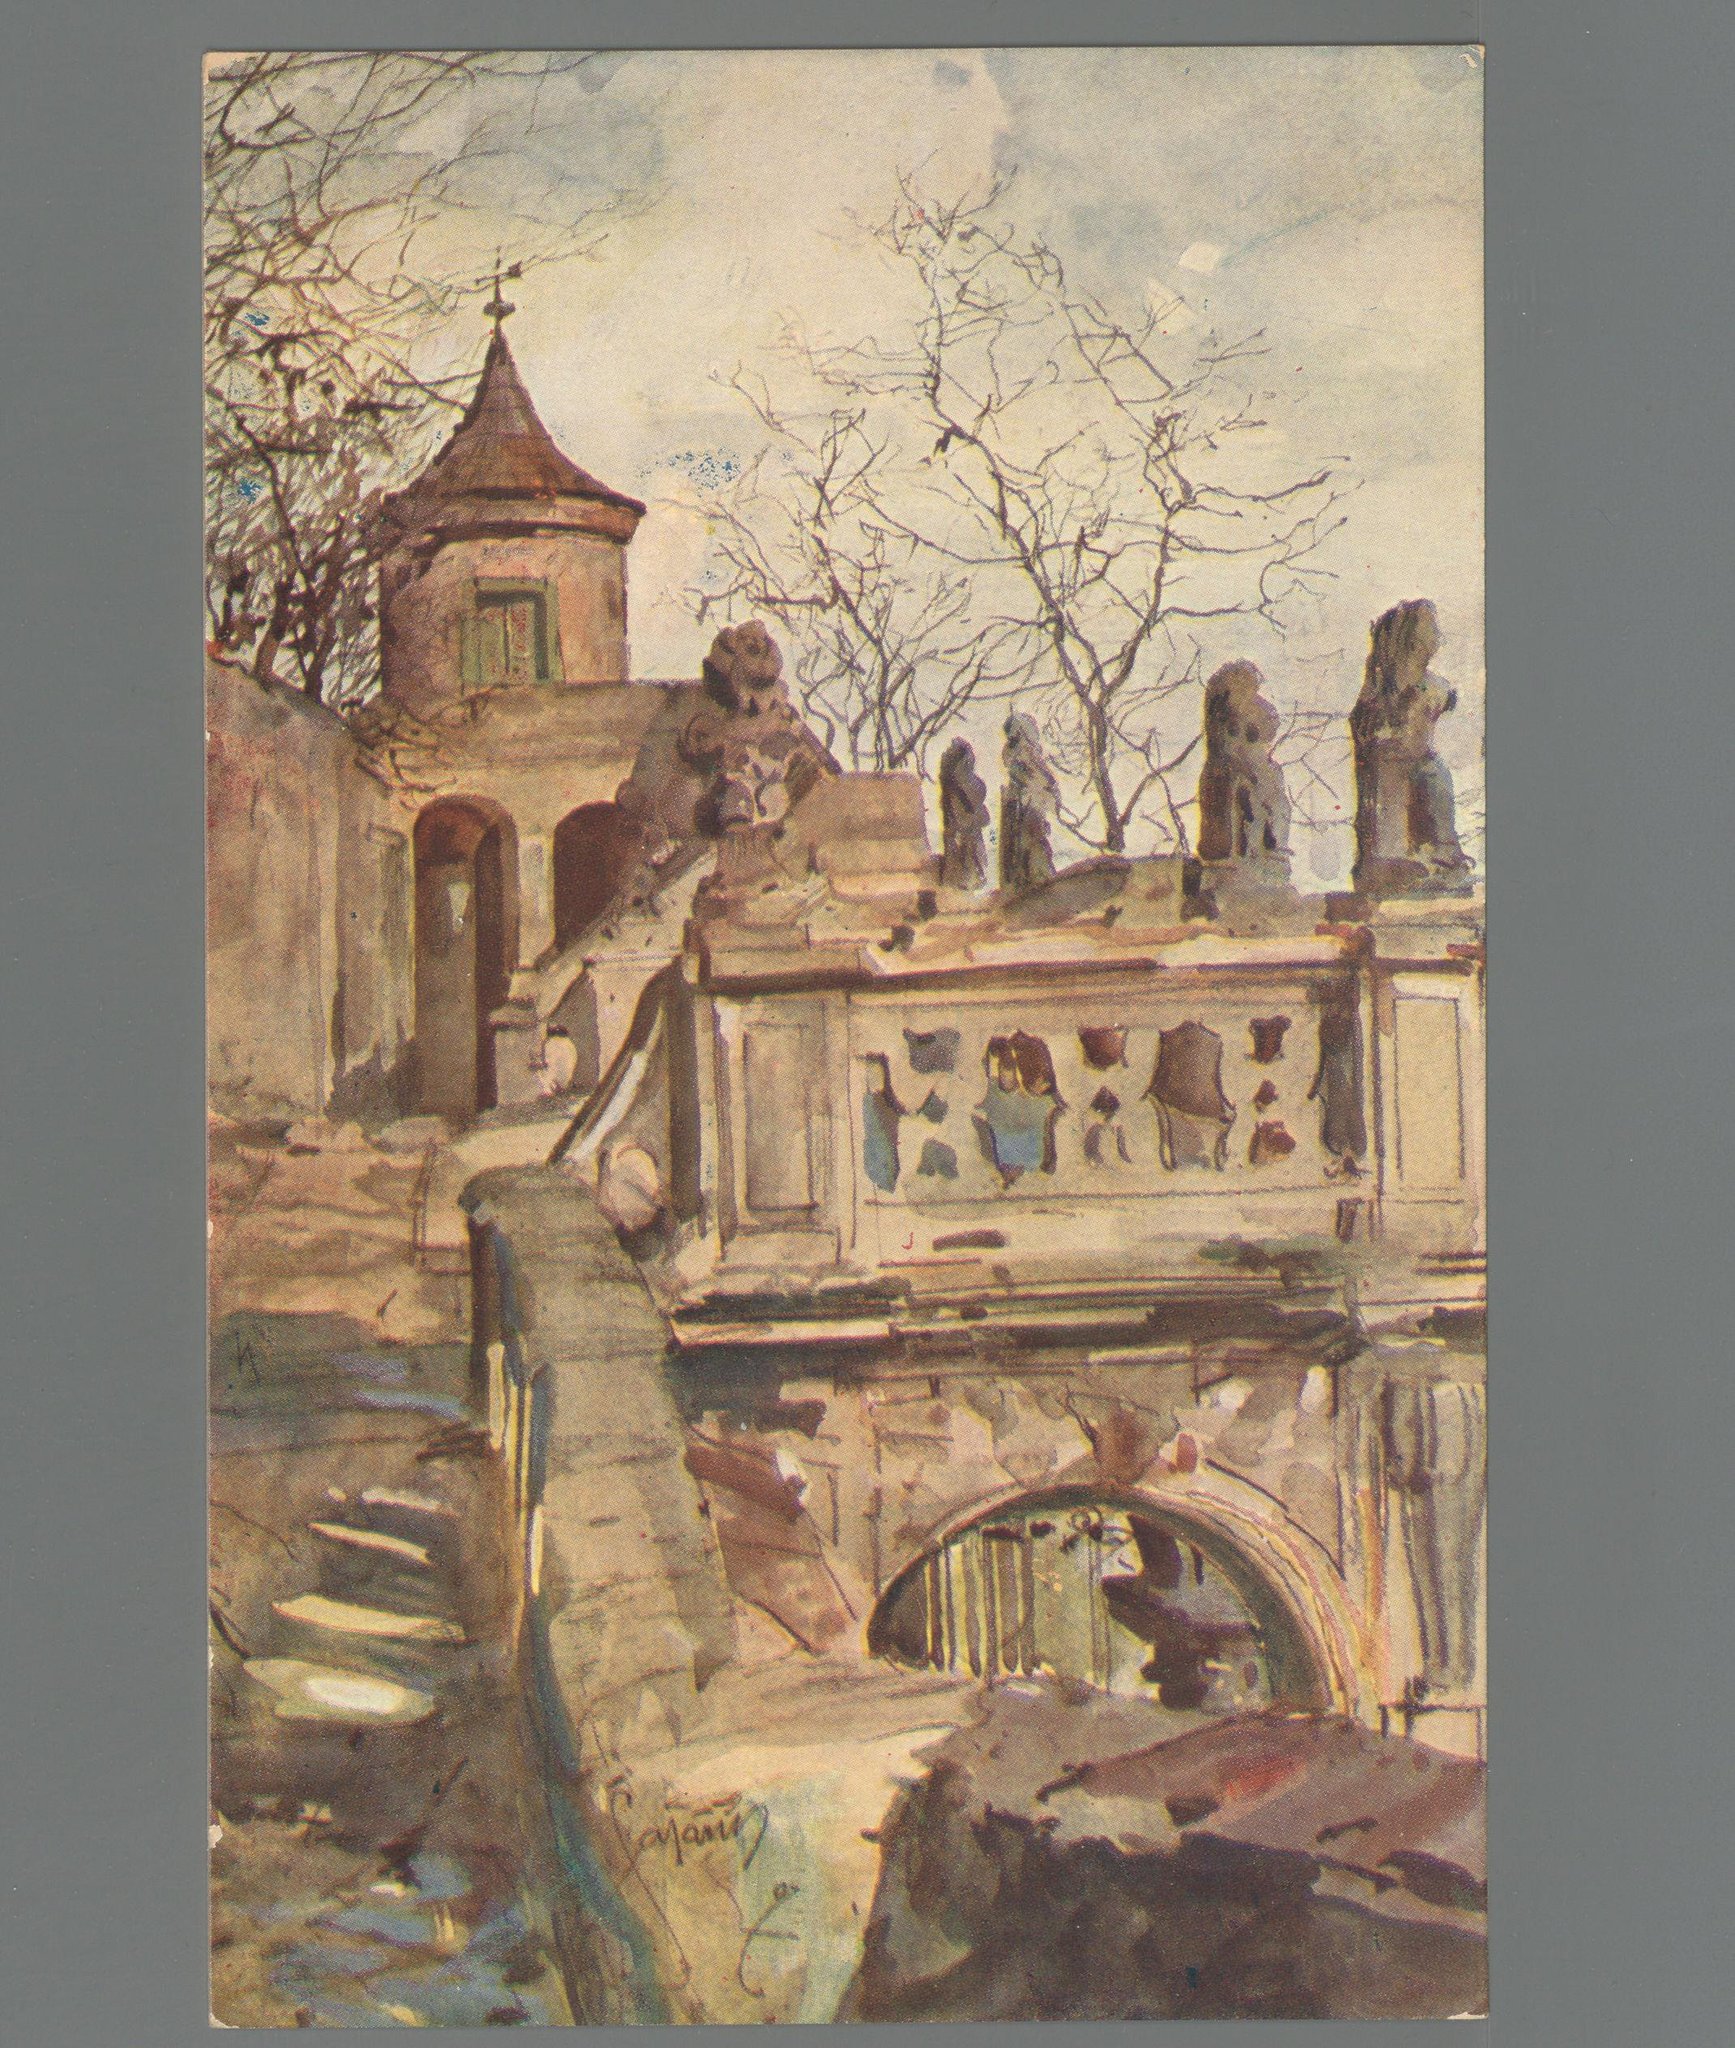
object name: ansichtkaart, prentbriefkaart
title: Gloriet ve Fürstenberské zahrade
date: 1906-1930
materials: cardboard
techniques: color autotype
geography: prague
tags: castle, garden, prague